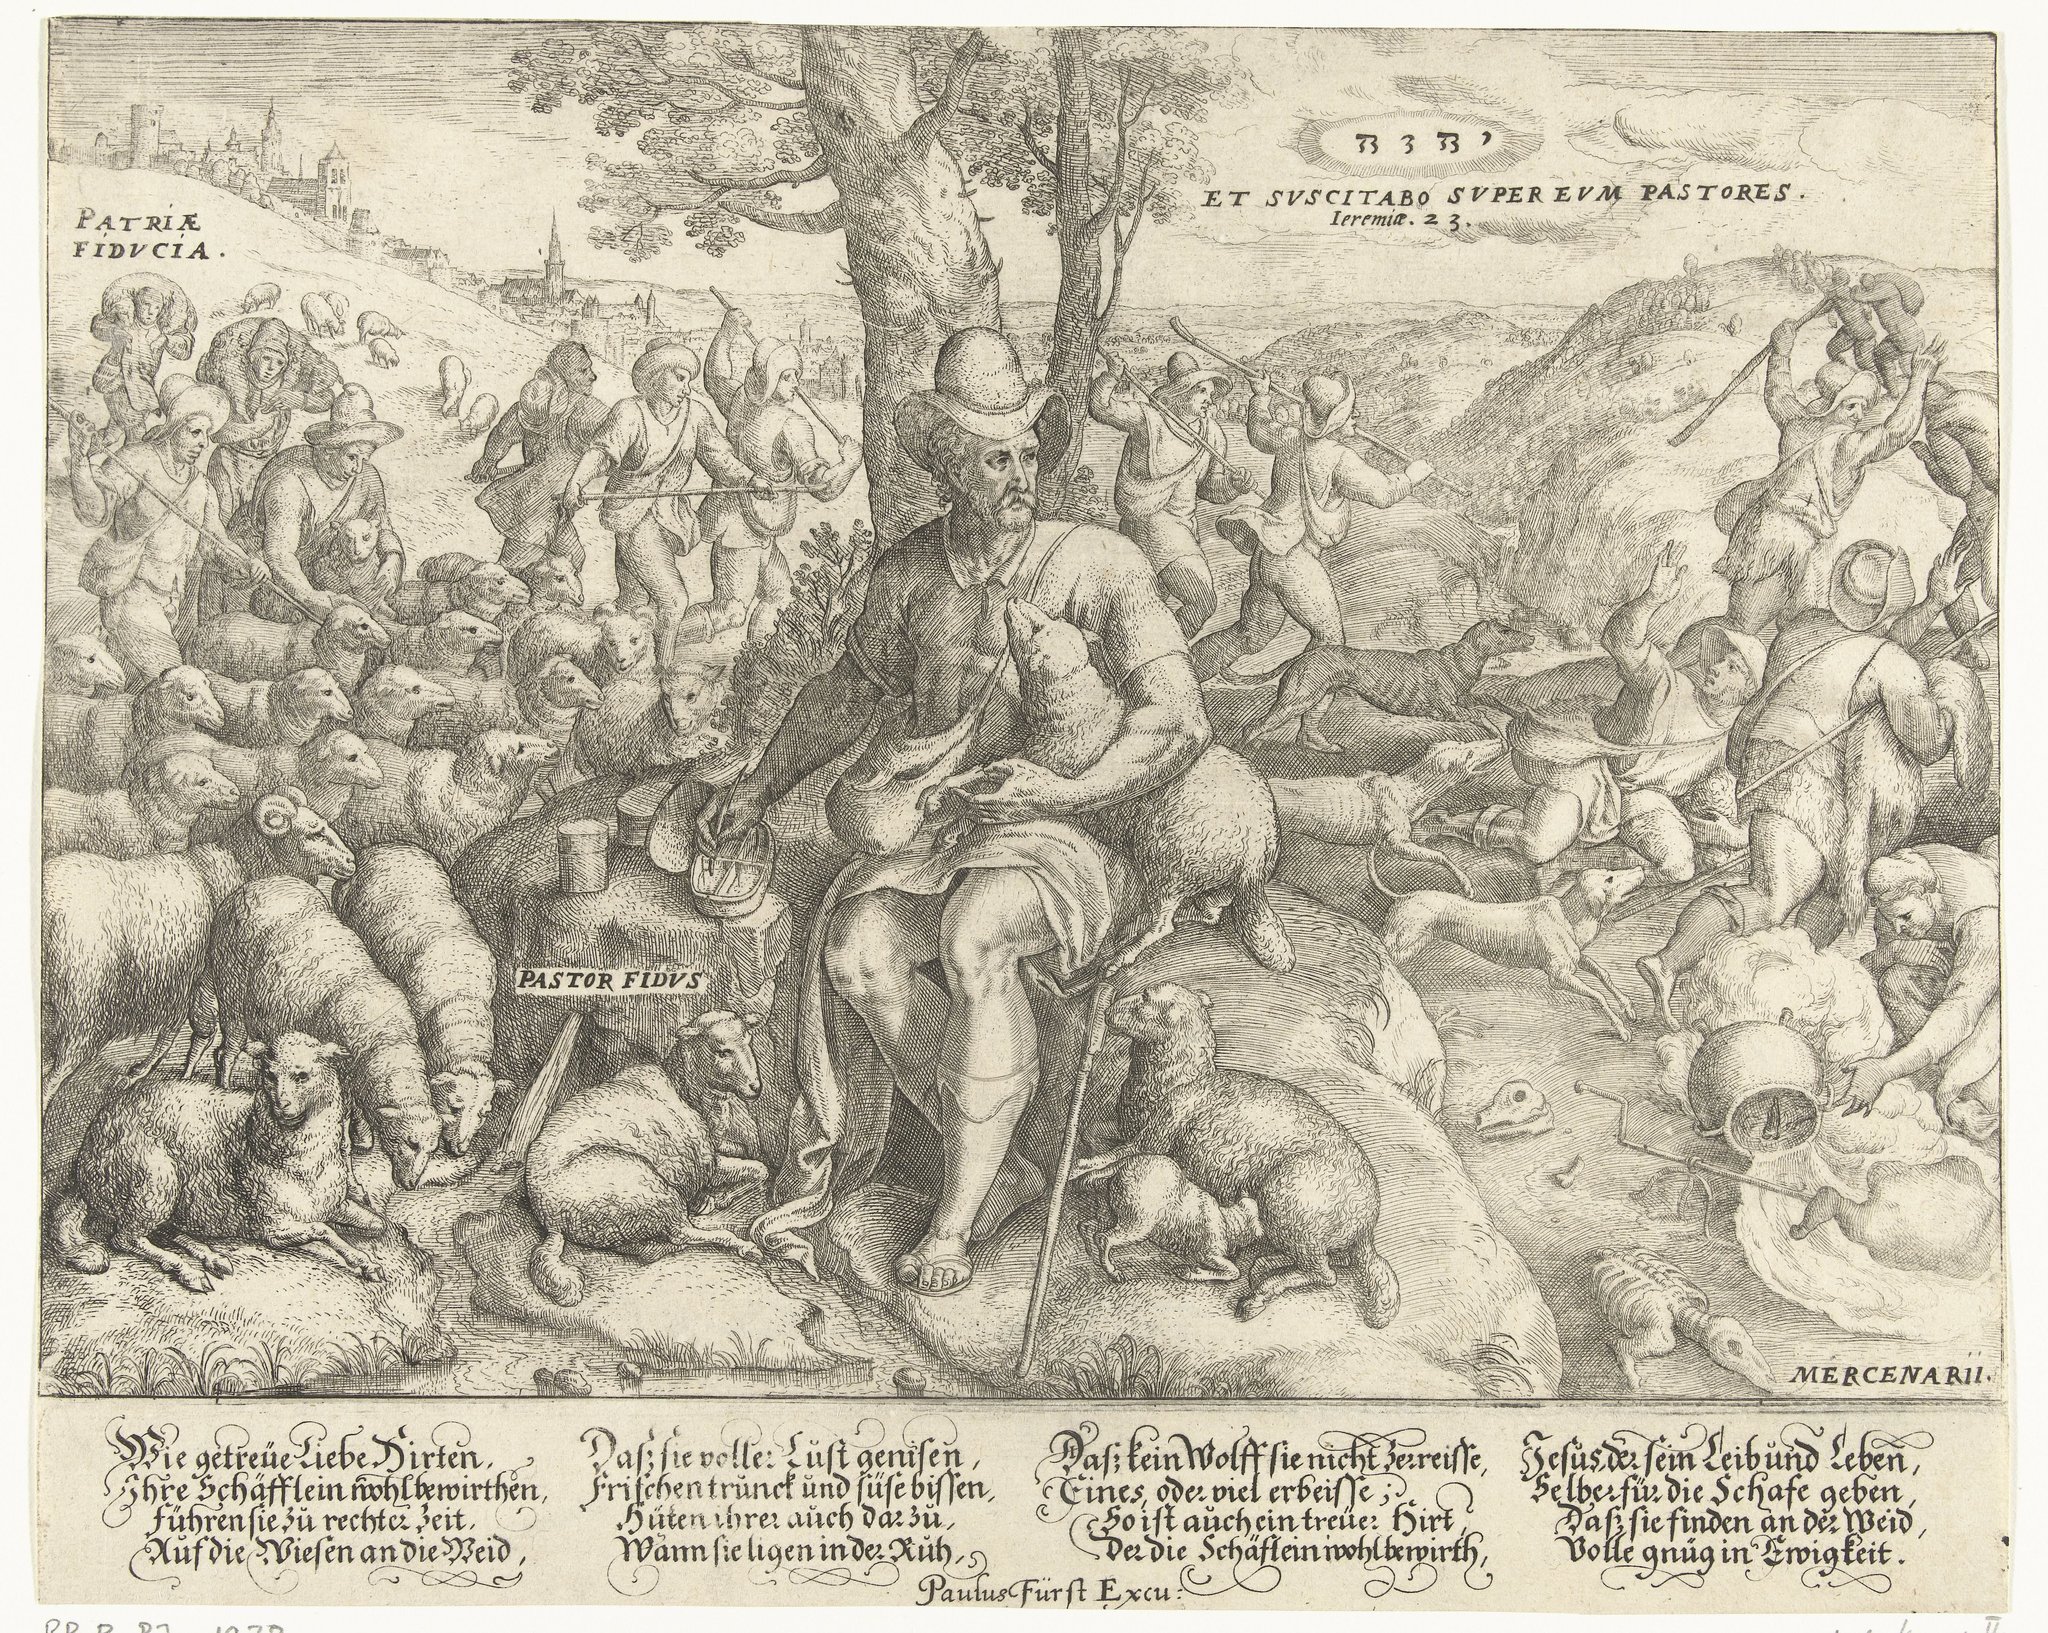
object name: print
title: Pastor Fidvs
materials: paper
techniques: etching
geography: southern netherlands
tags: the good shepherd (christ) defending his sheep against wolves; 'i am the good shepherd' (john 10:1-16)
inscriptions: collector's mark: Lugt 2165, collector's mark: Lugt 2228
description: Een herder verzorgt een schaap met een bezeerde poot. Rechts worden de huurlingen verjaagd die de schapen hebben gevangen om ze op te eten. Links zijn goede herders te zien die de schapen weer bijeen brengen. Twee van hen dragen een schaap op hun schouders. In de ondermarge een vers van vier coupletten in het Duits.